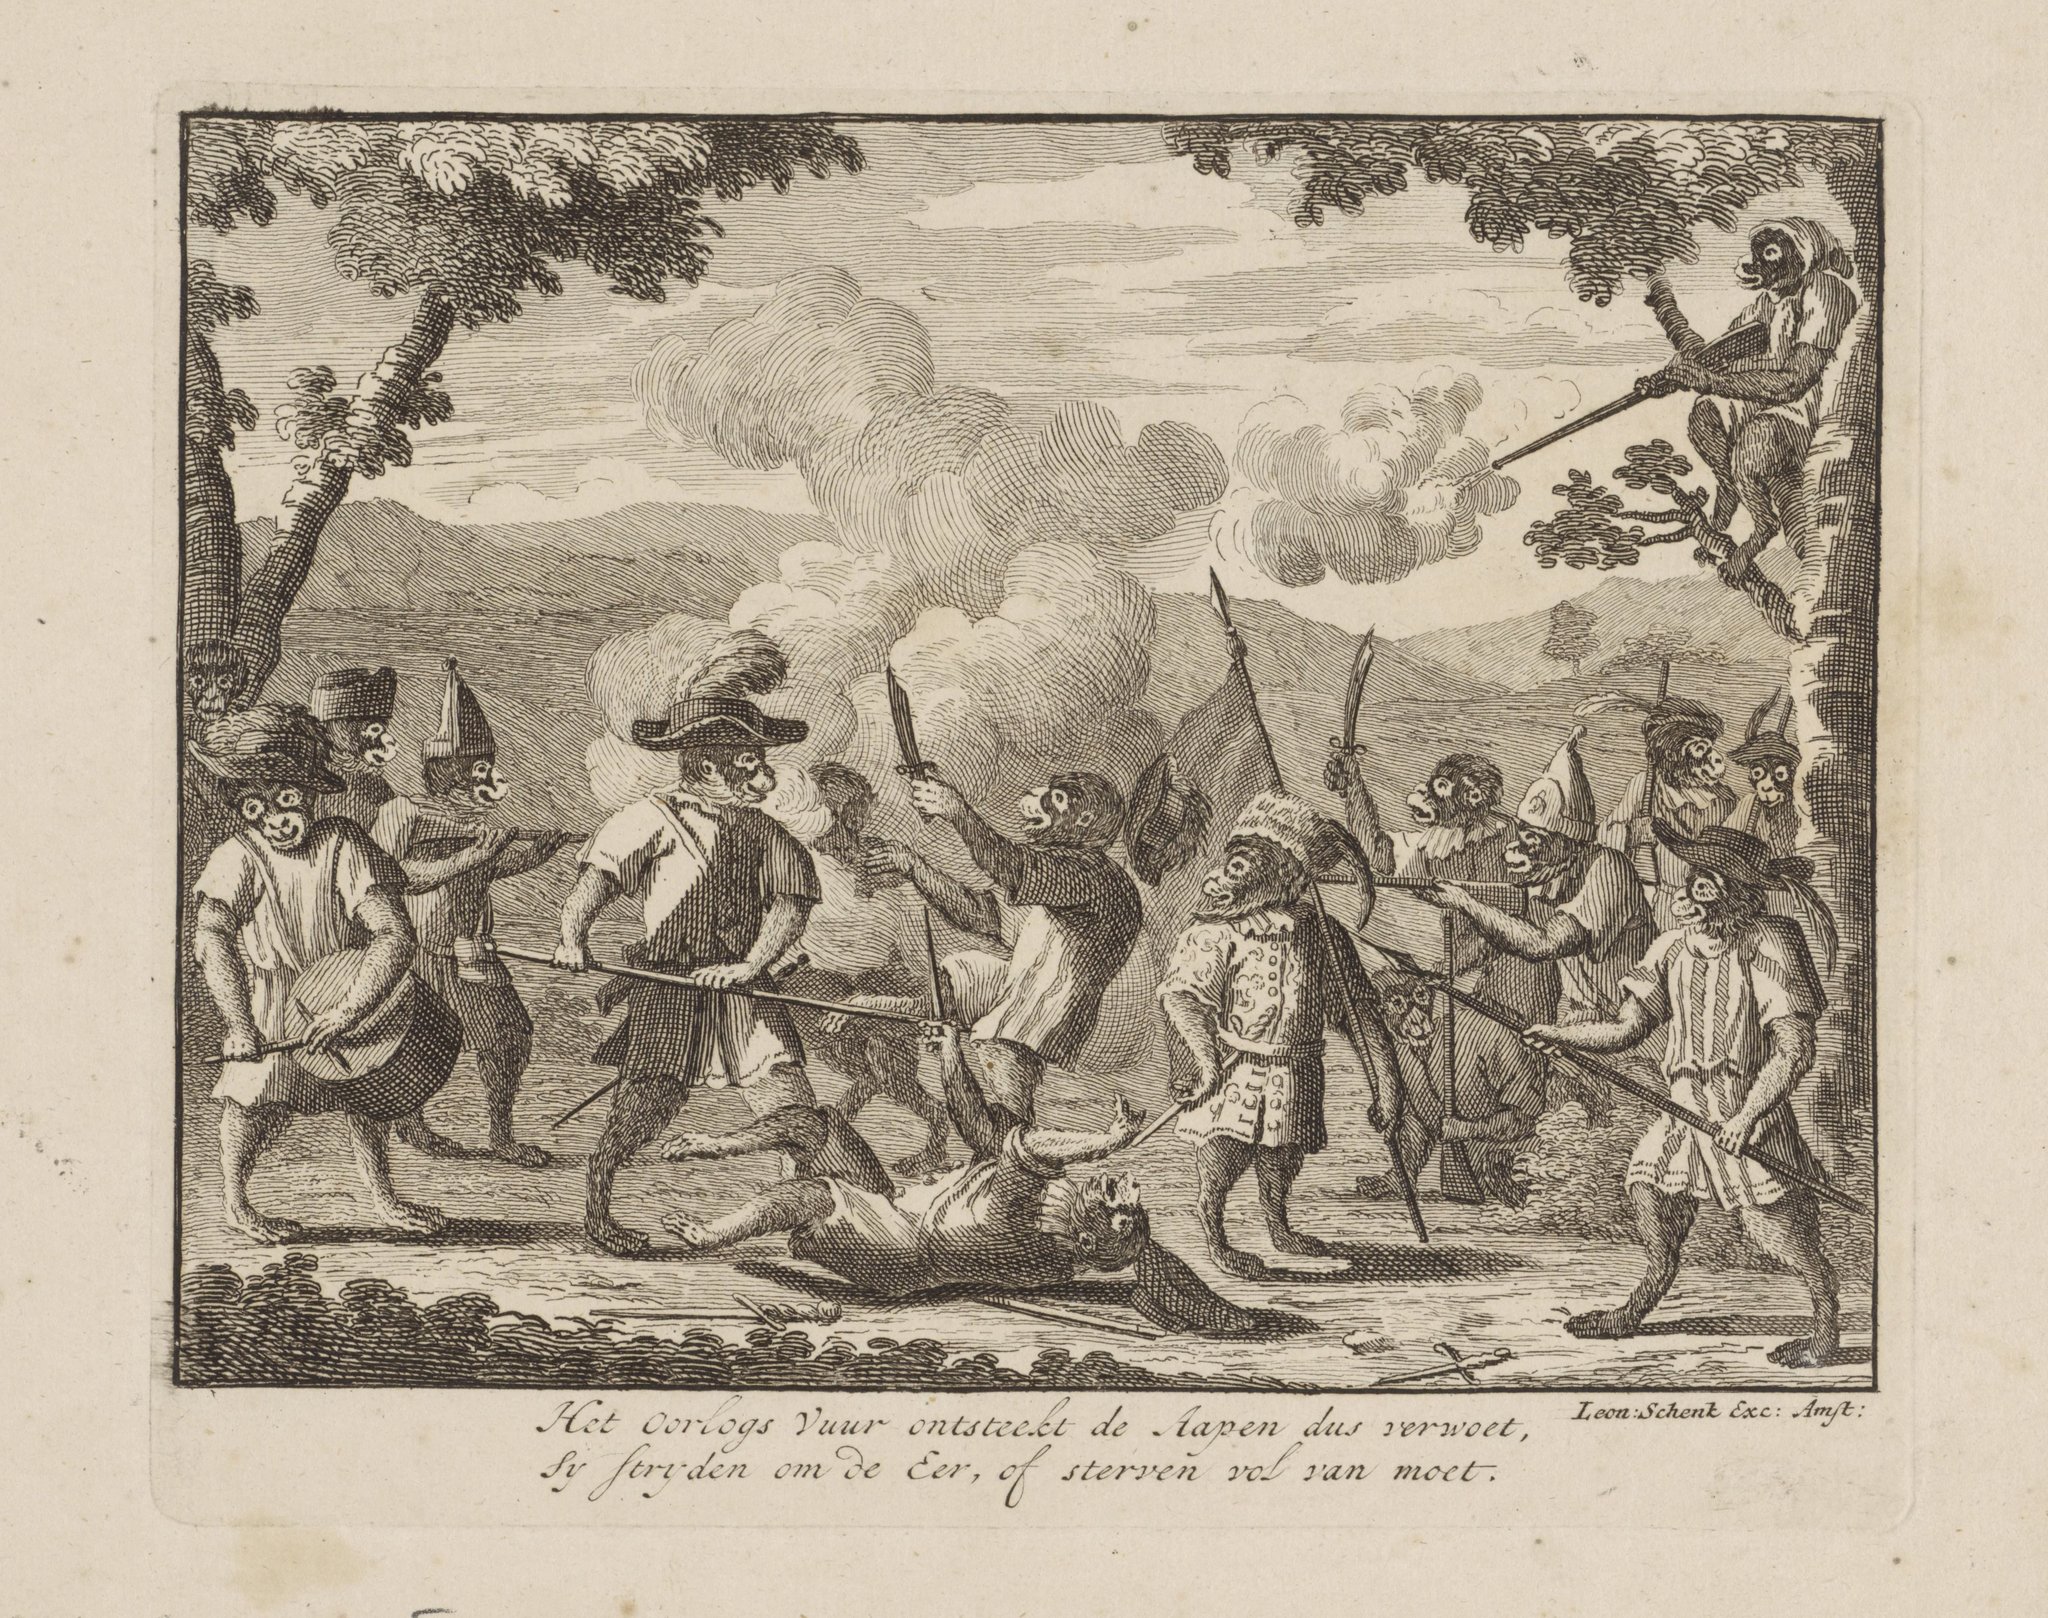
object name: print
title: Apenspel in de wereld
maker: leonard schenk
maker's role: print maker, publisher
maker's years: 1696-1767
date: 1720-1767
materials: paper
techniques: etching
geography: amsterdam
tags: monkeys, apes, animals acting as human beings, battle (+ land forces)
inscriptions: collector's mark: Lugt 2228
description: Met speren en geweren bewapende apen strijden tegen elkaar. Rechts vuurt een aap vanuit een boom een geweer af. In het midden ligt een aap op de grond. Onderdeel van een serie bestaande uit een titelprent en platen waarin apen als mensen figureren in allerlei taferelen uit het dagelijks leven. De prent heeft een tweeregelig vers in het Nederlands.